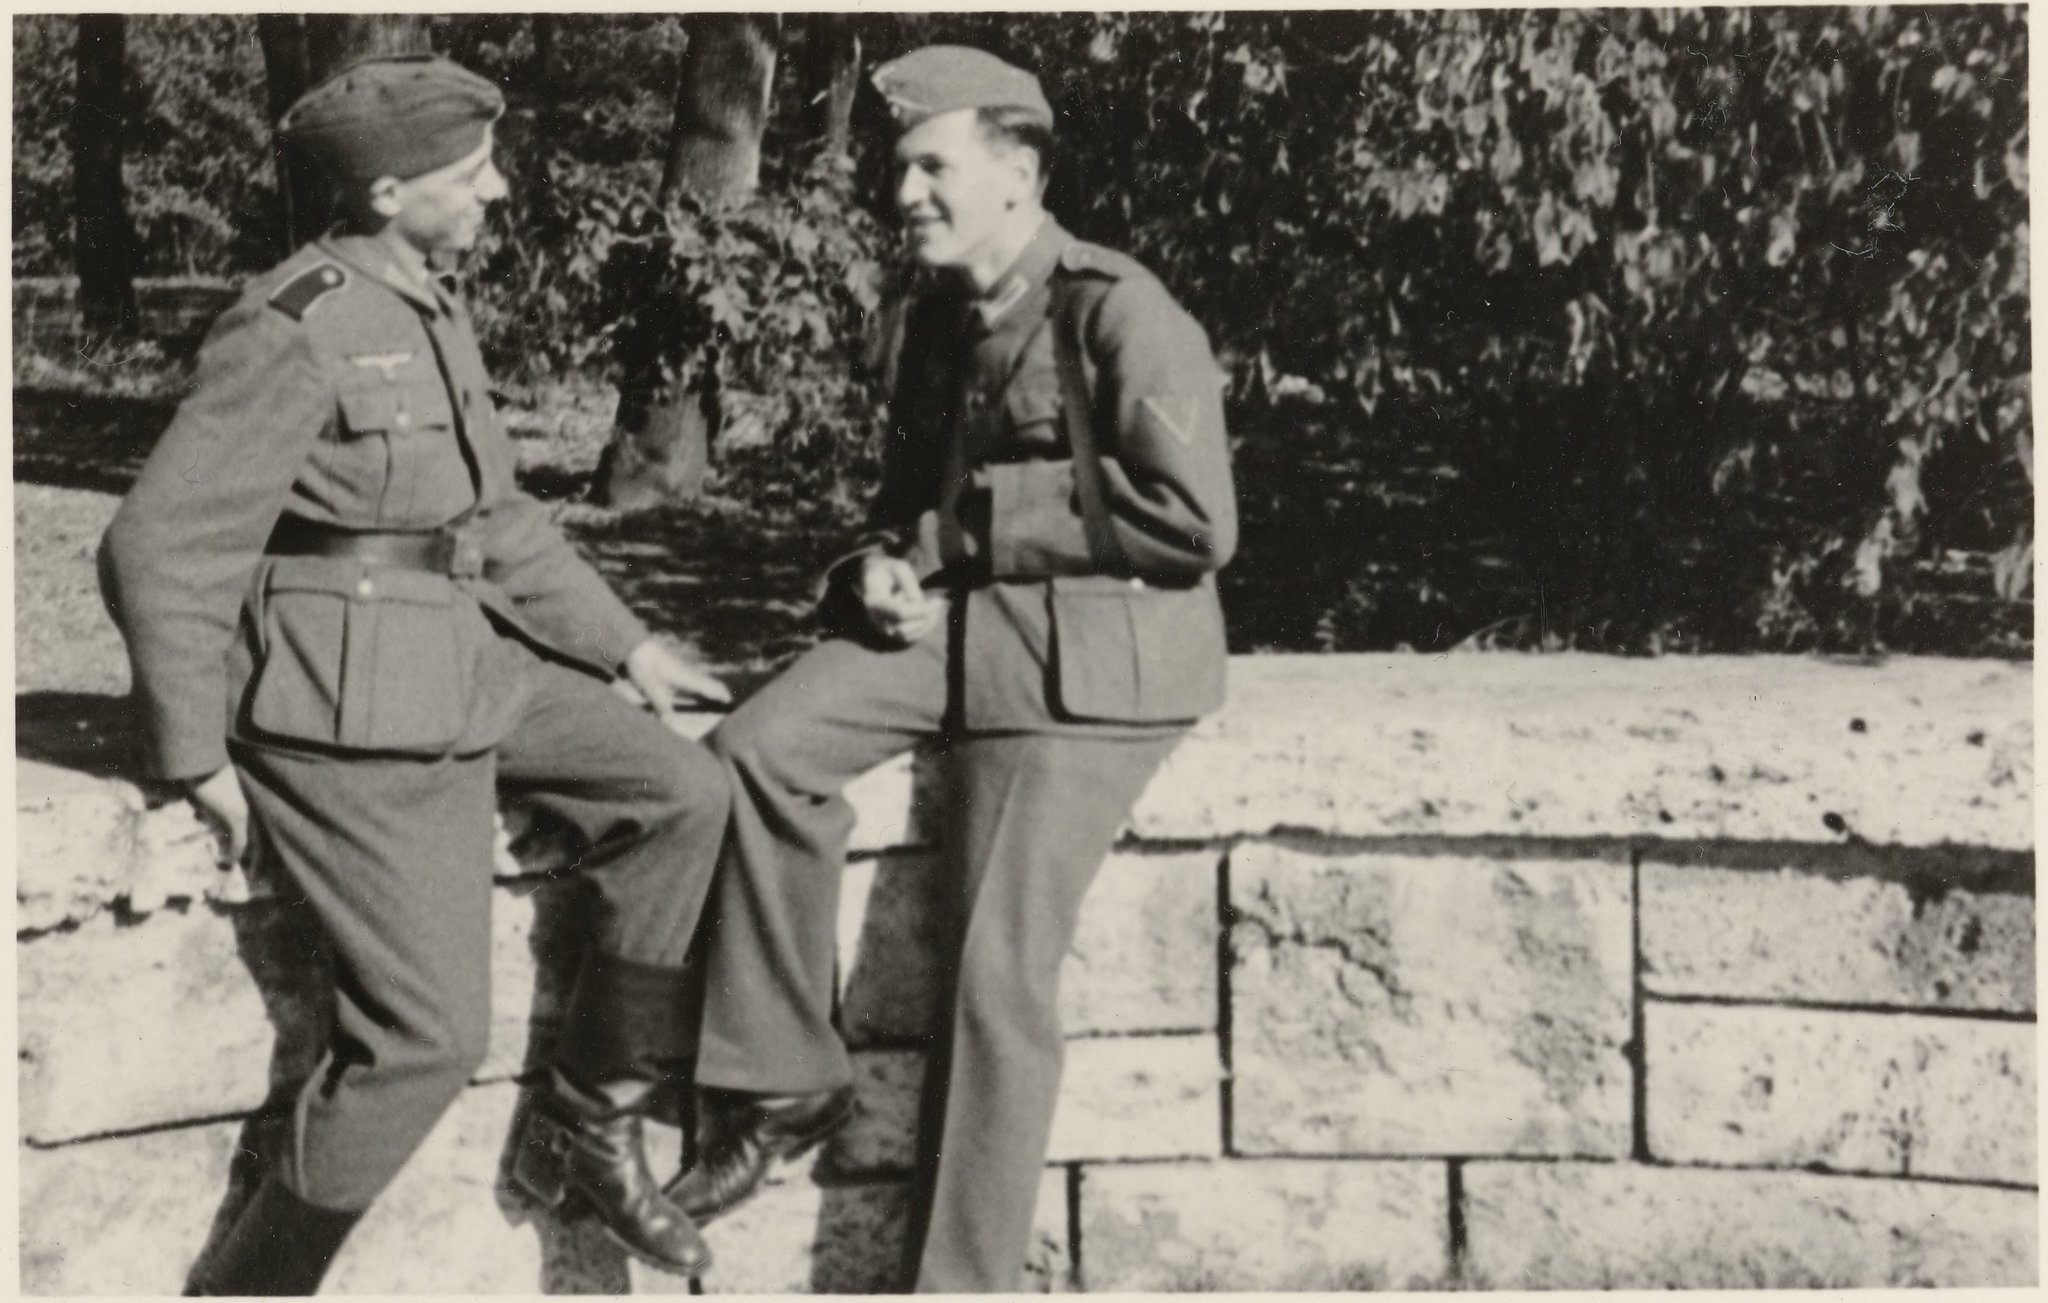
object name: photograph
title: Twee leden van de Wehrmacht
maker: Anonymous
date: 1940-1945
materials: photographic support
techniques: gelatin silver print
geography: france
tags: netherlands, germany, france, belgium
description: Twee leden van de Wehrmacht zitten op een stenen muur. De rechter soldaat heeft zijn arm in een soort mitella. Foto behorend bij album 'Kriegserinnerungen'.